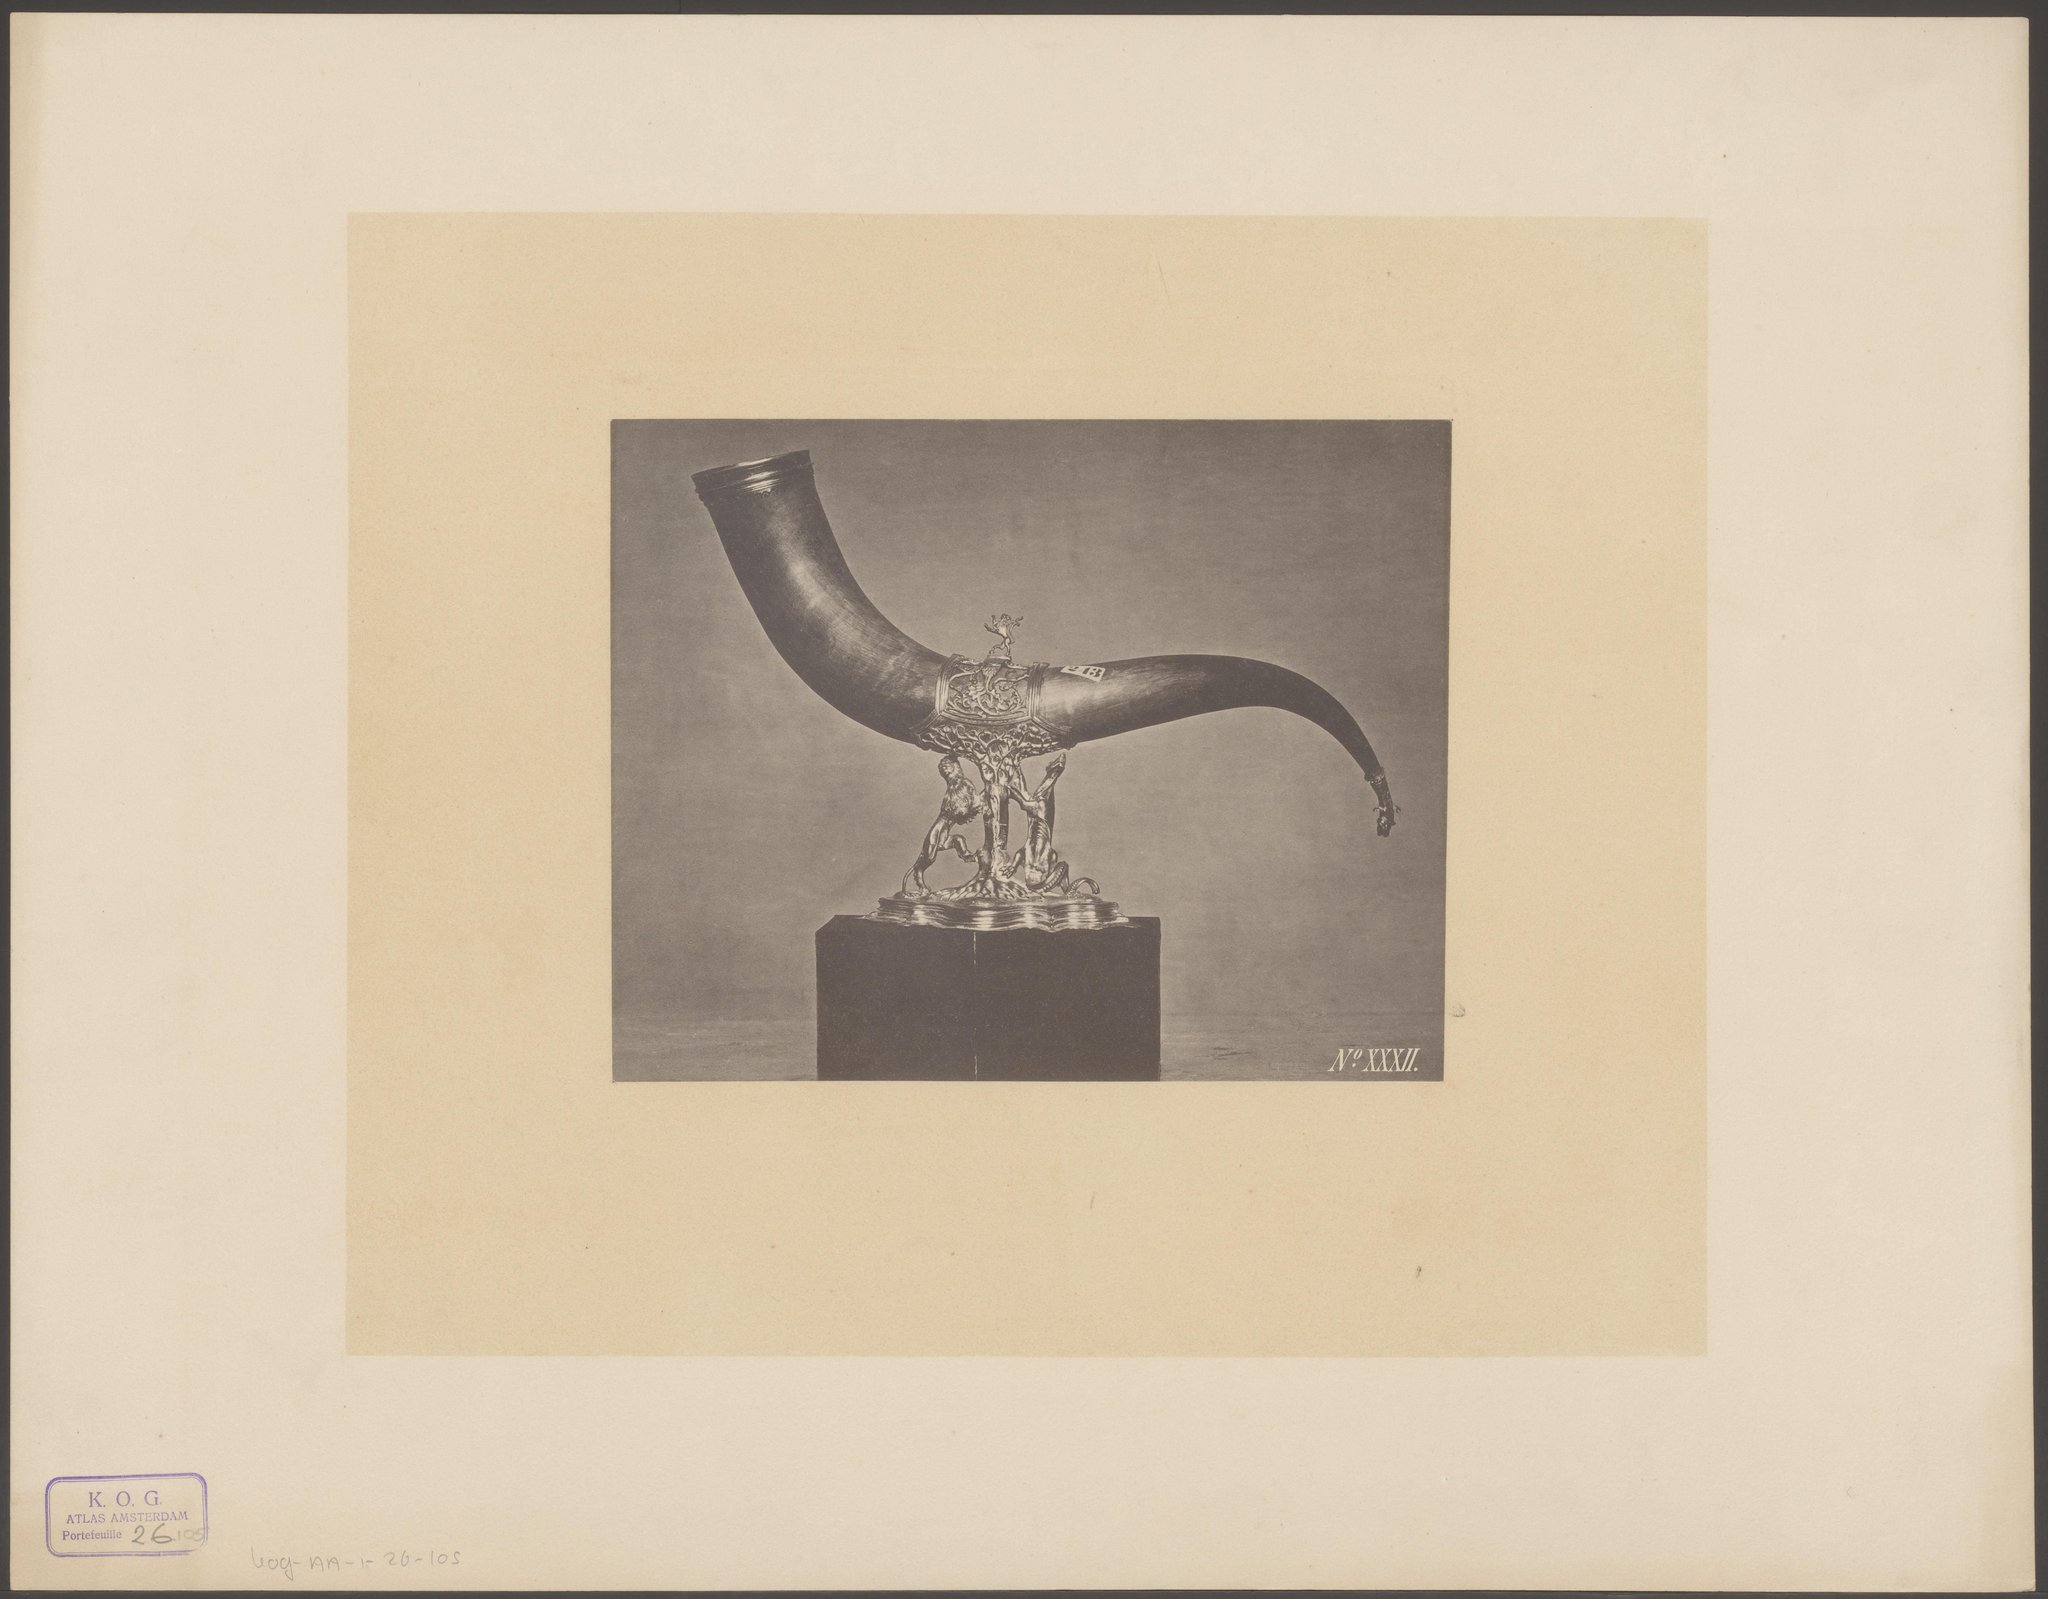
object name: photomechanical print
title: Drinkhoorn van het kloveniersgilde van Amsterdam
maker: Anonymous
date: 1875-1884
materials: paper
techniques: photograph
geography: netherlands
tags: insignia of a guild, drinking-horn, amsterdam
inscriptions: collector's mark: Lugt 1641b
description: Rechtsonder genummerd: No. XXXII. Onderwerpsrubriek binnen de Atlas Amsterdam: Herinneringen aan de Schutterij.